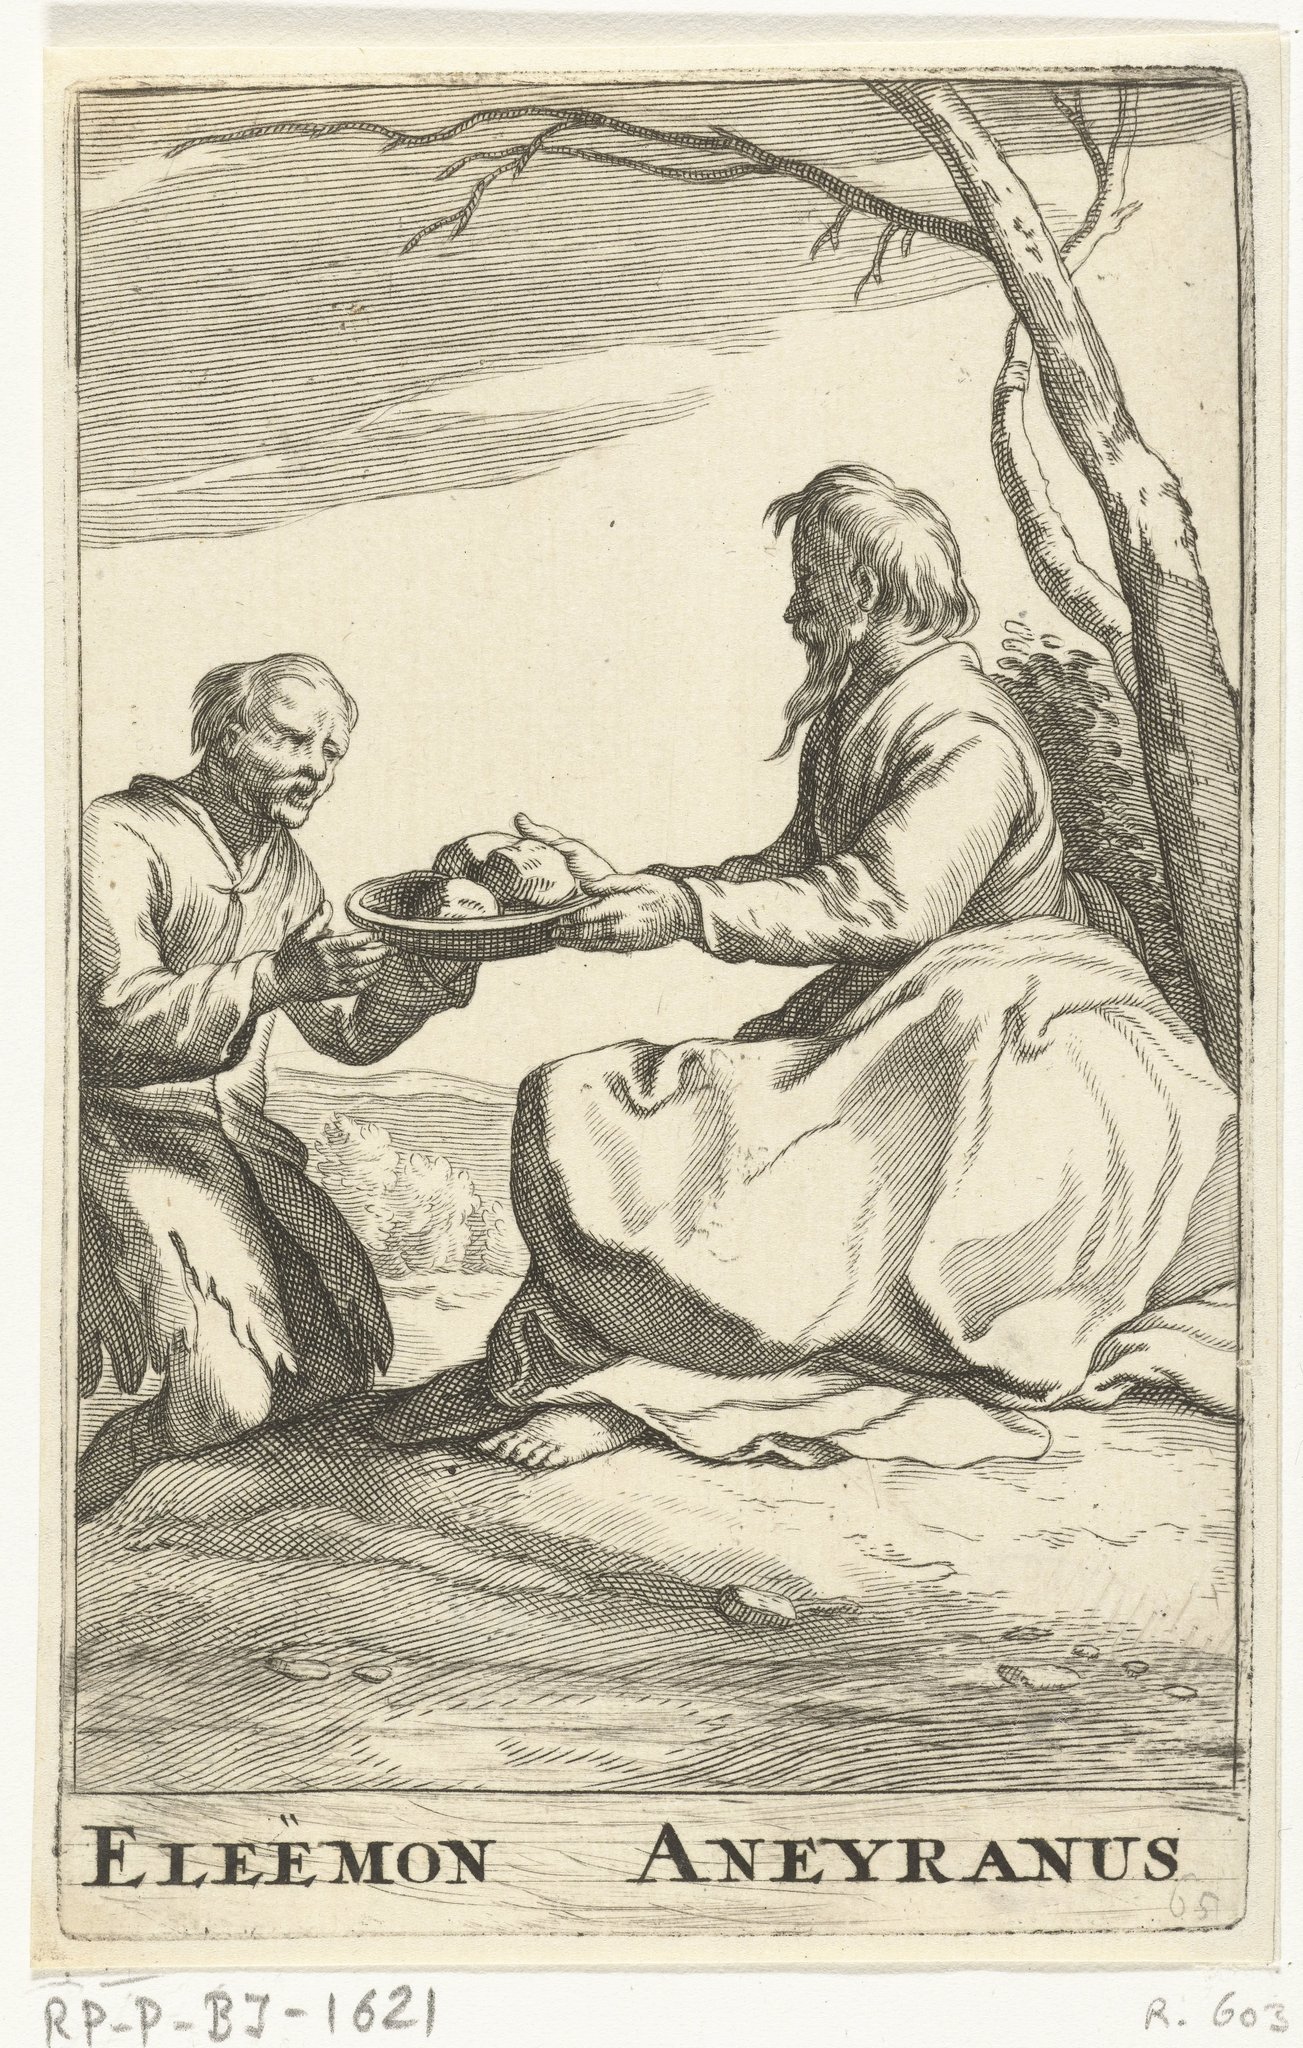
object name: print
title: Heilige Eleëmon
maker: frederick bloemaert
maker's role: print maker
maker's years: 1614-1669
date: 1636-1670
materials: paper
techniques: engraving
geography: utrecht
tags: male saints (with name)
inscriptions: number: ‘65’, collector's mark: Lugt 240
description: De heilige Eleëmon zit onder een boom en geeft een bedelaar te eten. Prent uit een serie van 80 prenten en een titelprent met kluizenaars uit de 2e tot de 6e eeuw.